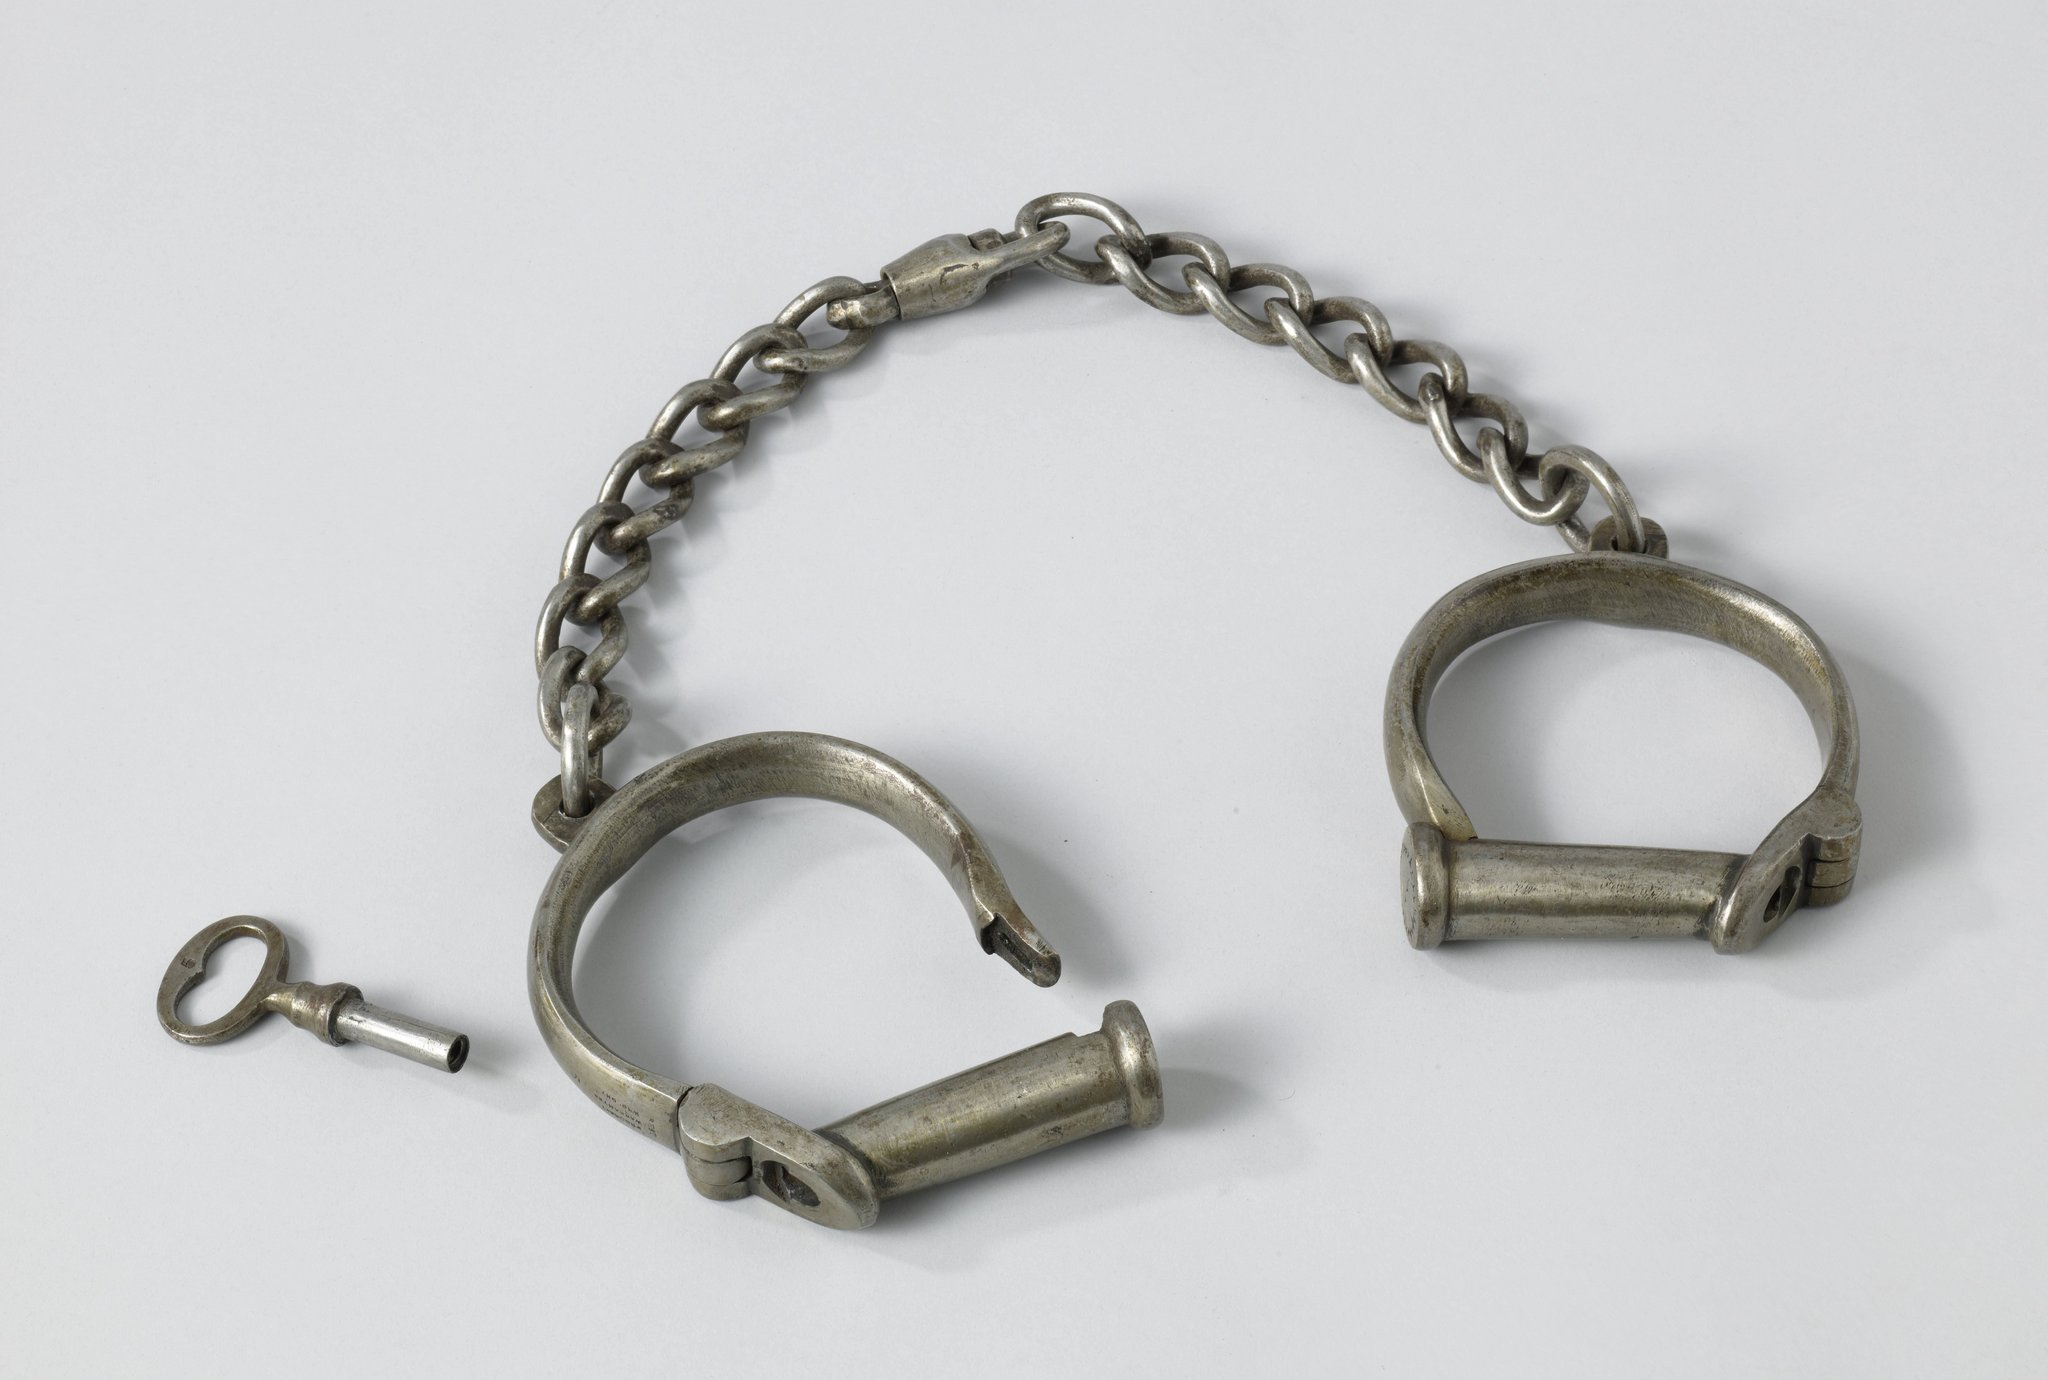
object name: voetboeien, kluister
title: Pair of Legcuffs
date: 1860-1866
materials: iron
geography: birmingham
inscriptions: inscription, on the key: ‘5’, inscription, on both cuffs, near the key: ‘BEST / FROGATT / WARANTED / WROUGHT / 5 ’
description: Een paar ijzeren voetboeien, verbonden door een ketting, met sleutel. Het slot werkt met een eenvoudige pal waarin de beugel valt; de sleutel loopt op een schroefdraad, die deze pal terugtrekt. Beide boeien en de sleutel zijn gemerkt '5'.